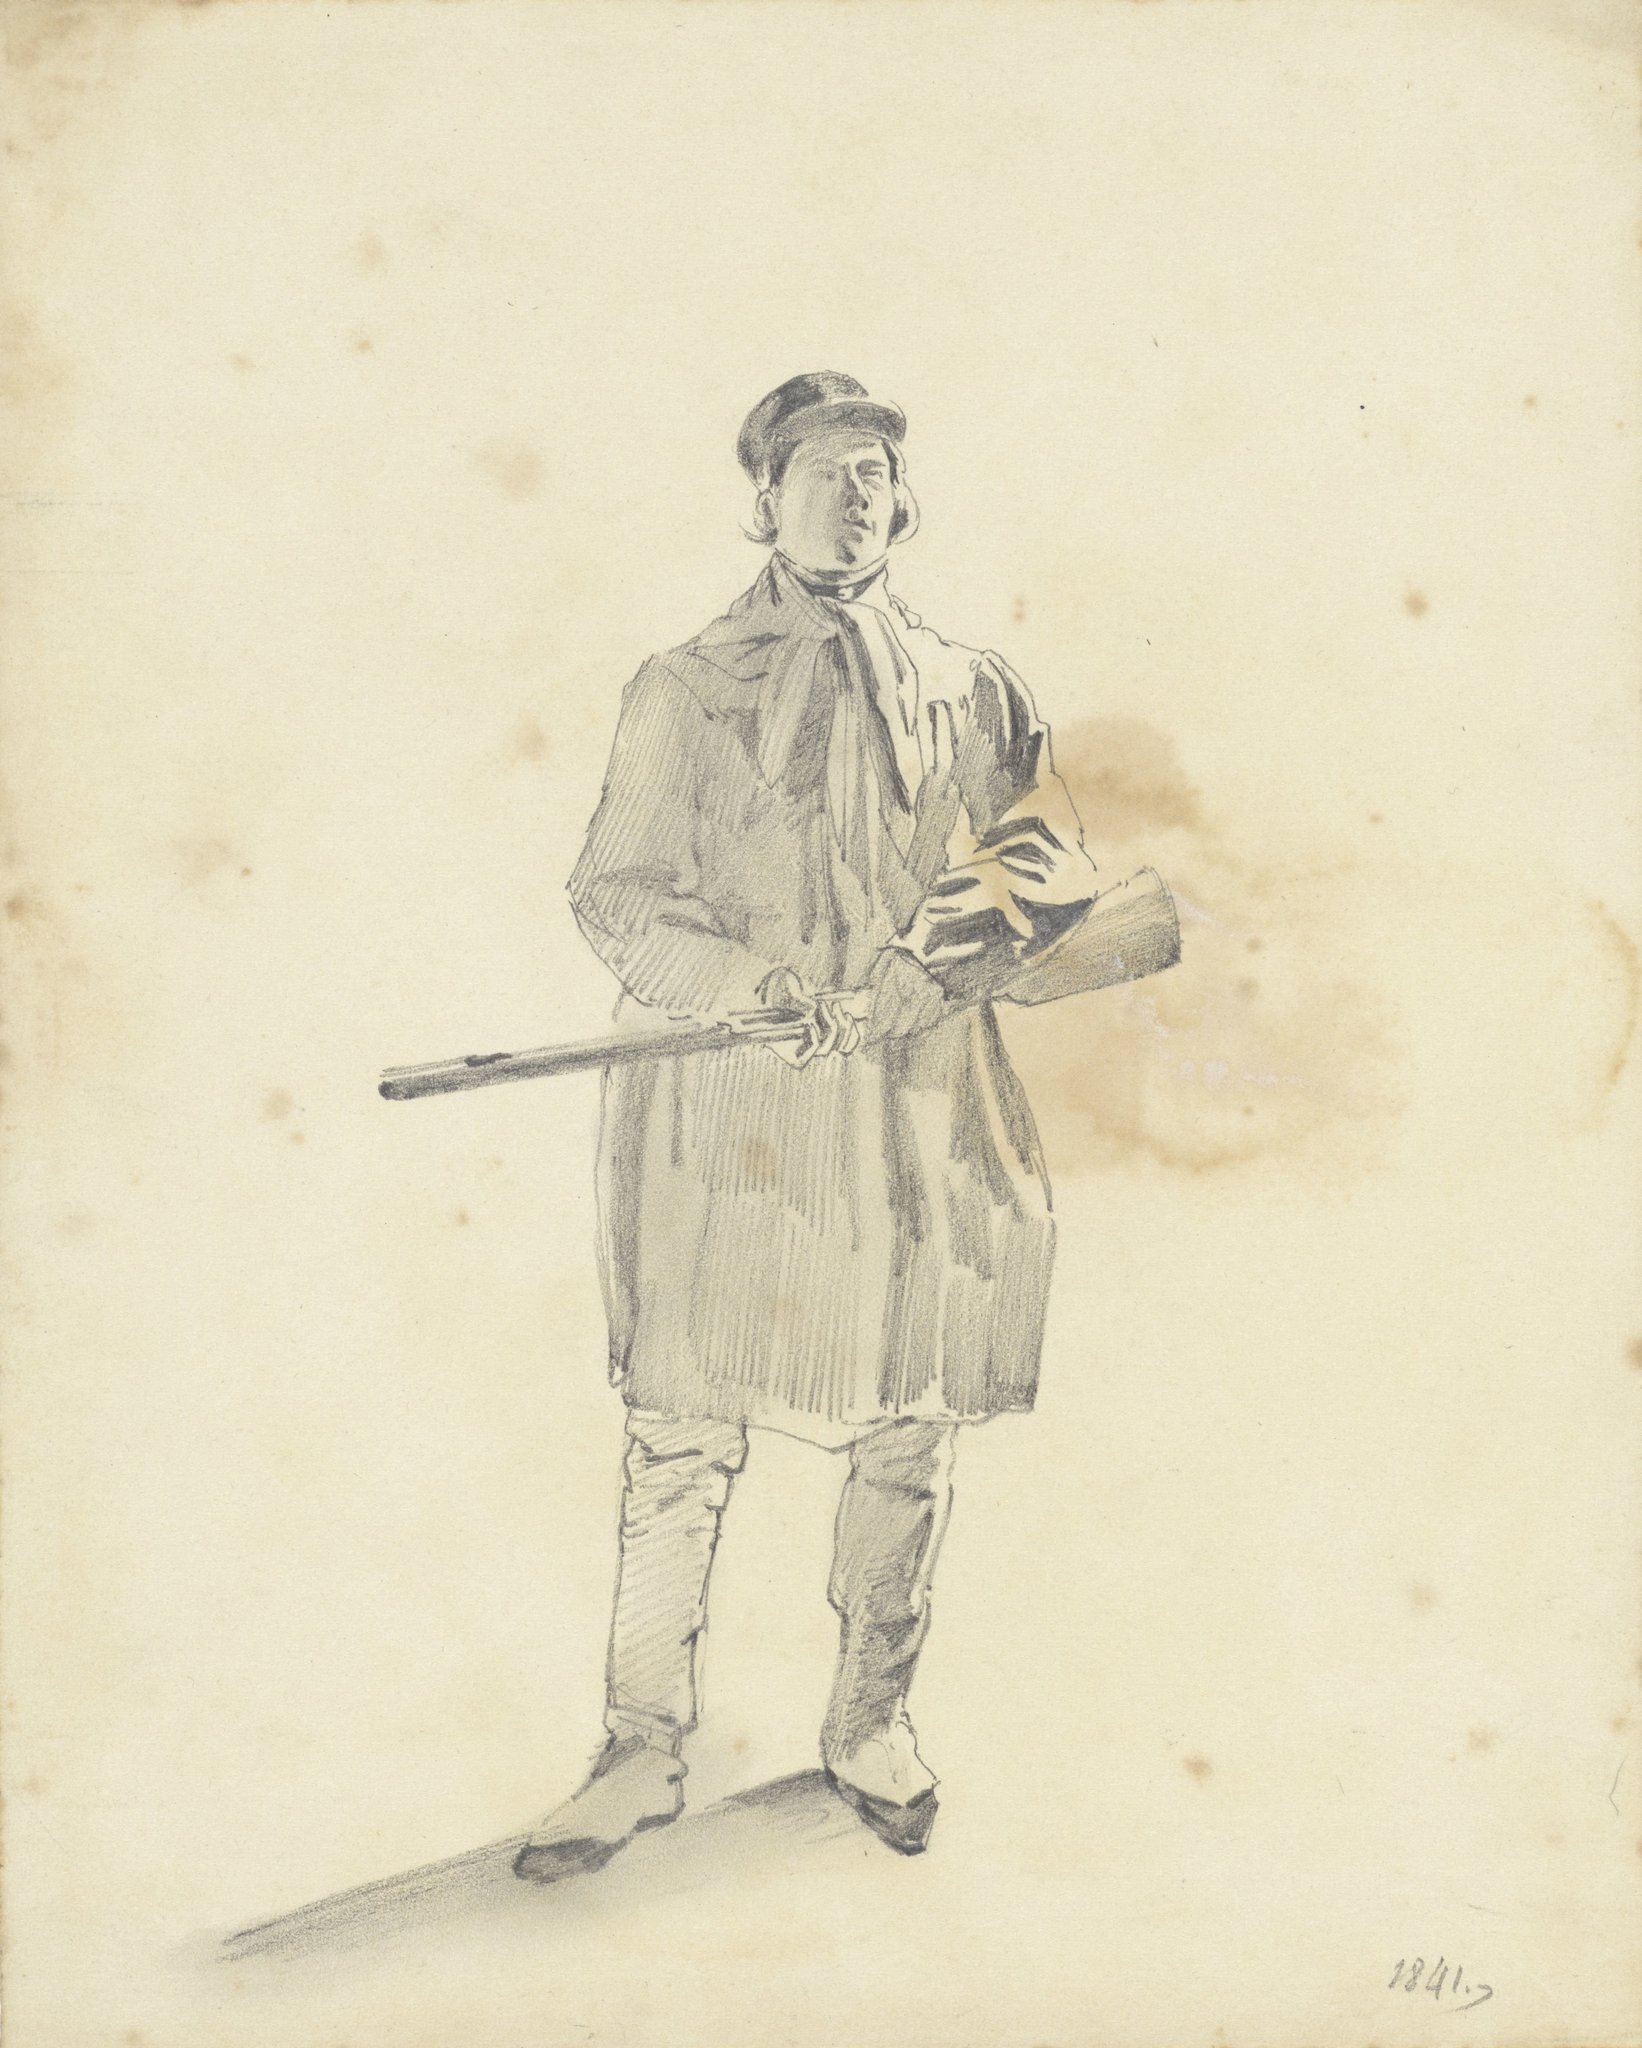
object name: drawing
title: Staande man met een jachtgeweer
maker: pieter van loon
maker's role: draughtsman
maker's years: 1801-1873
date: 1841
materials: paper, pencil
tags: hunter